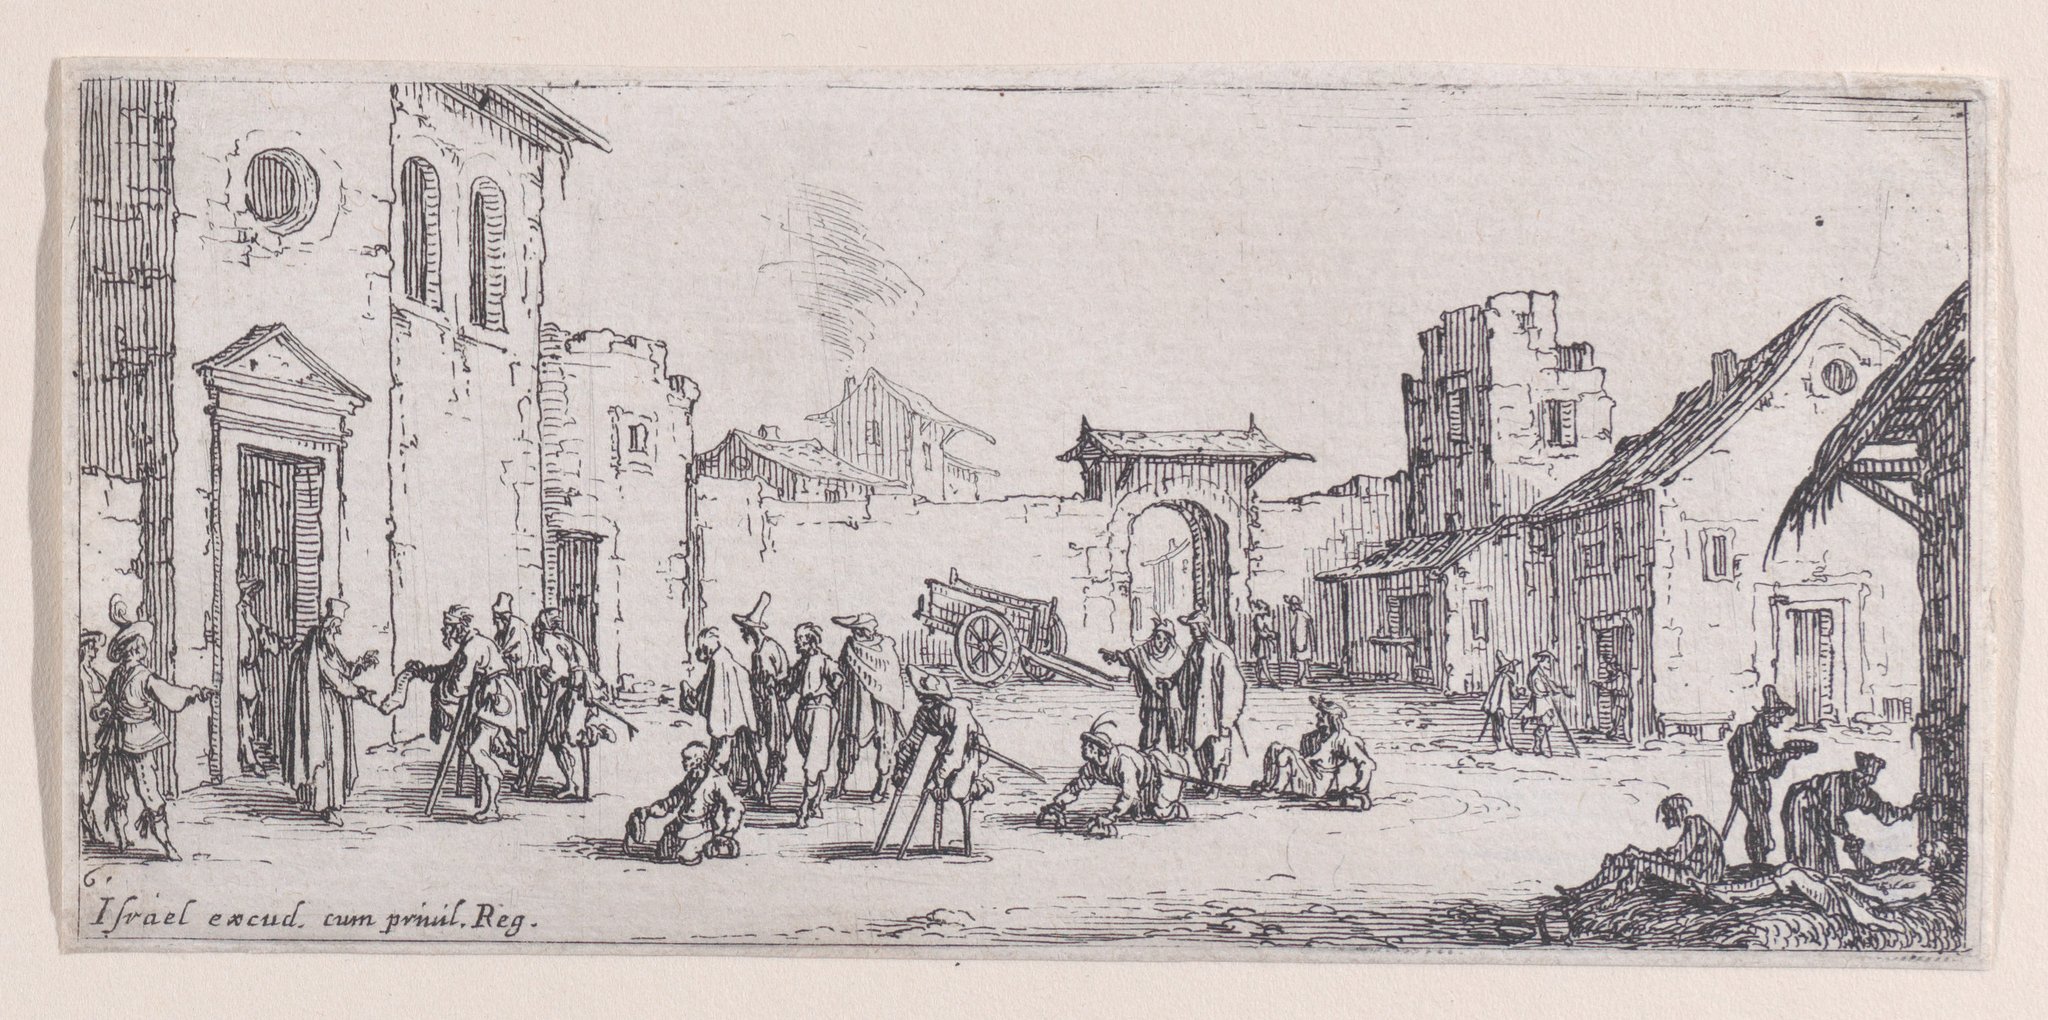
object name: print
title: L'Hopital (The Hospital), plate 6 from "Les Petites Misères de la Guerre" (The Little Miseries of War)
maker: jacques callot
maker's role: artist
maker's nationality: french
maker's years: 1592-1635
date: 1636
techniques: etching